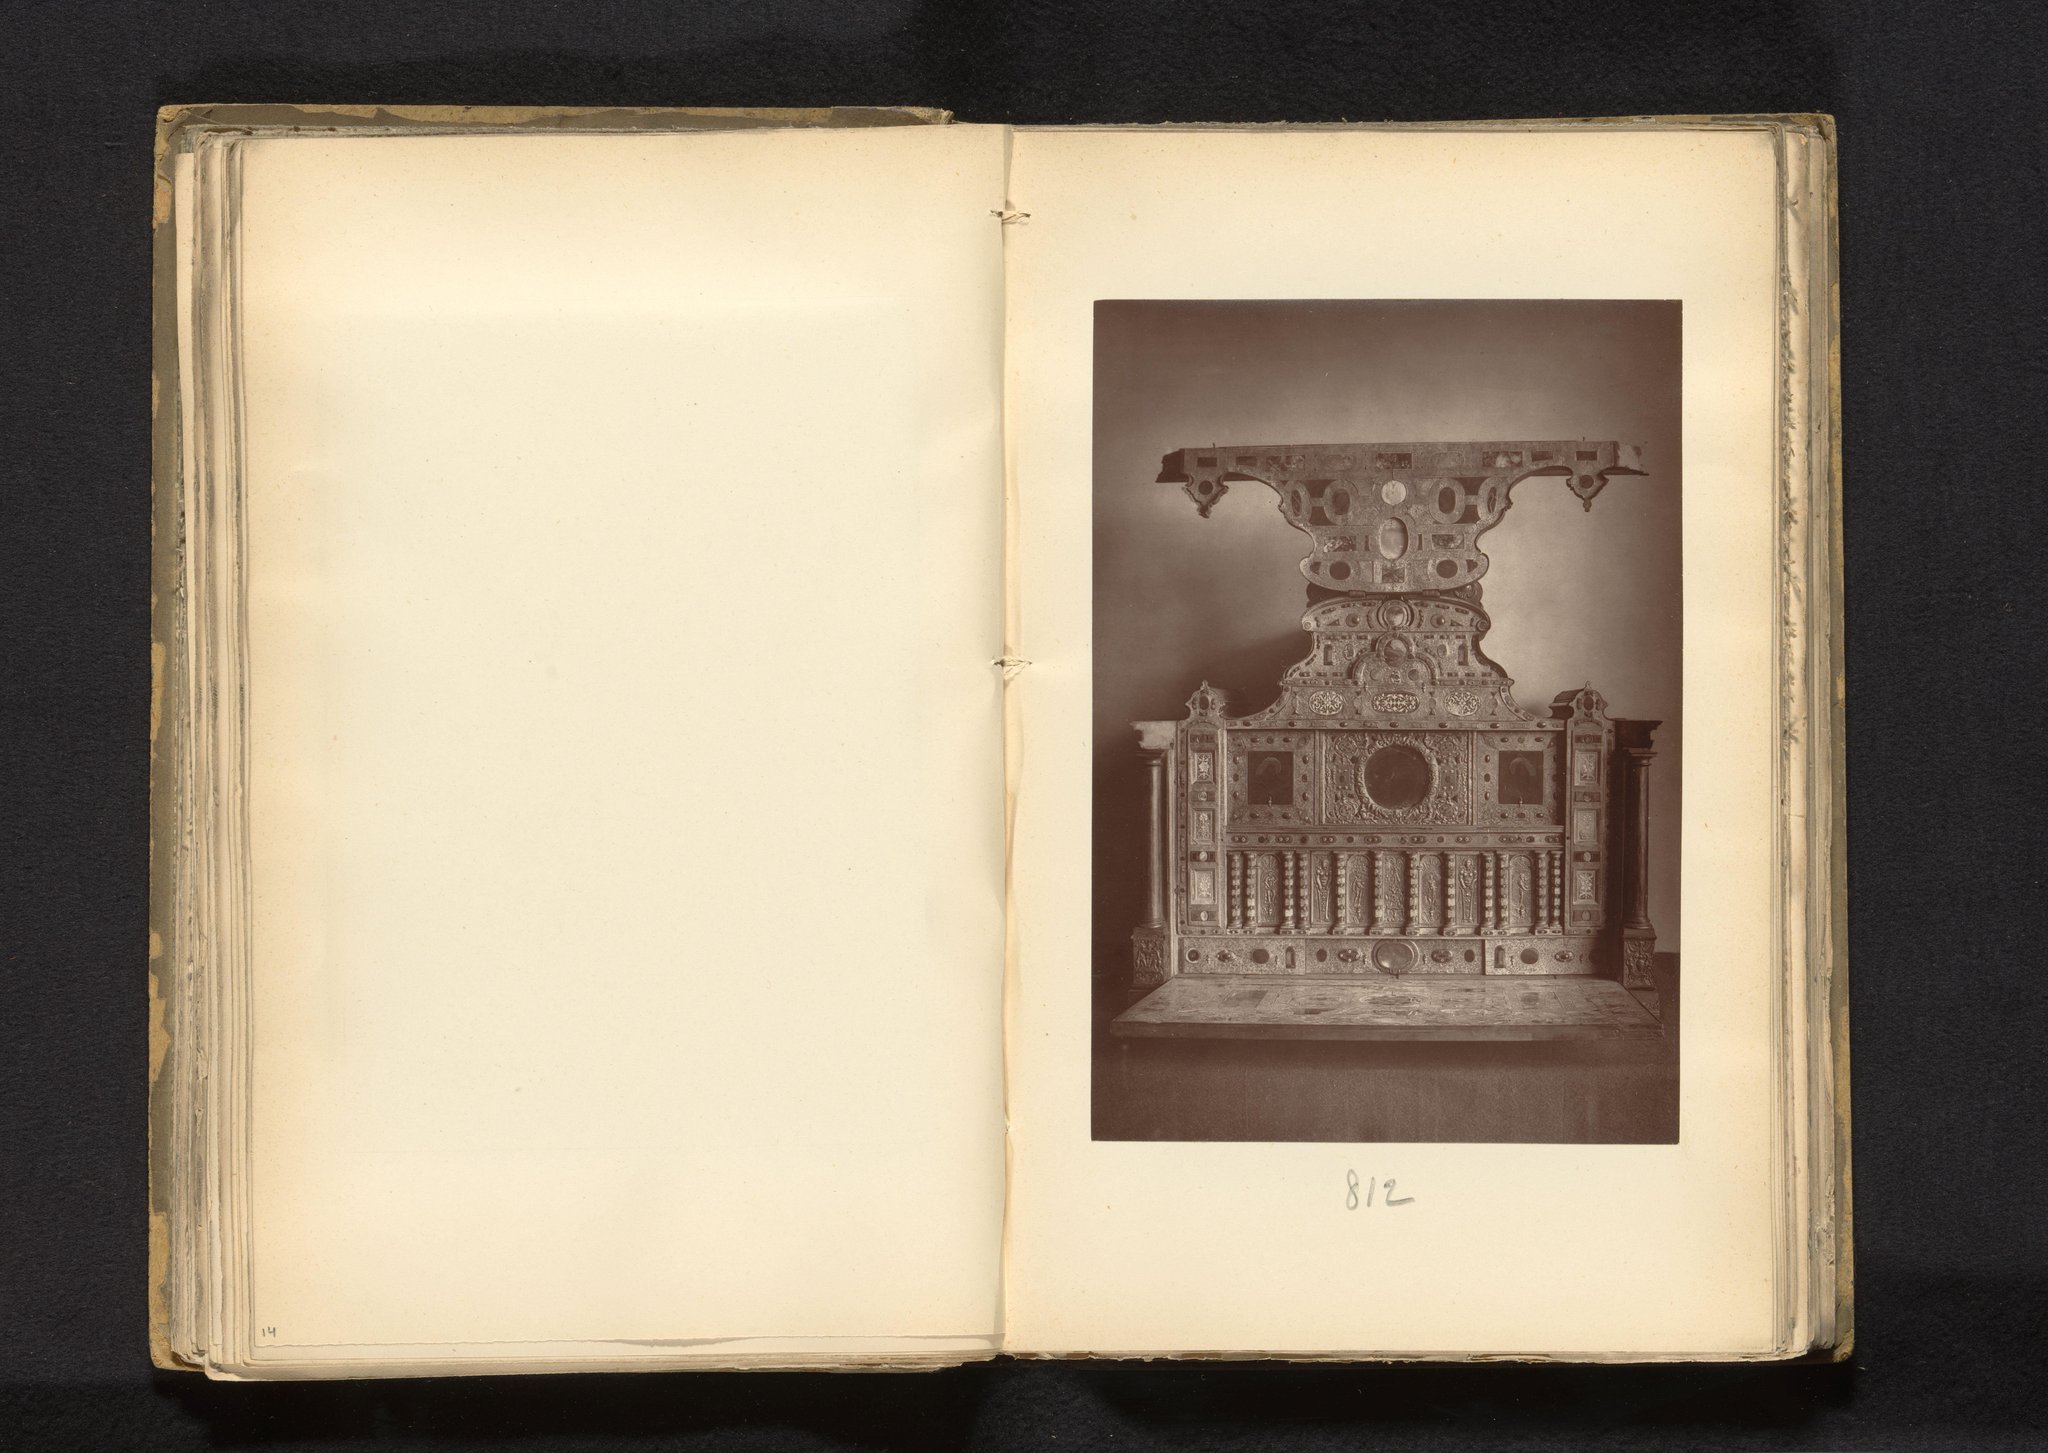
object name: page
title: Kabinet gedecoreerd met metaal, uit de collectie van Christopher Beckett Denison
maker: Anonymous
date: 1880-1885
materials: paper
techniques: woodburytype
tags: ornamental cupboard (+ wood and other phytogenic material)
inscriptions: number: ‘812’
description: Prent op derde ongenummerde pagina na pagina 80.